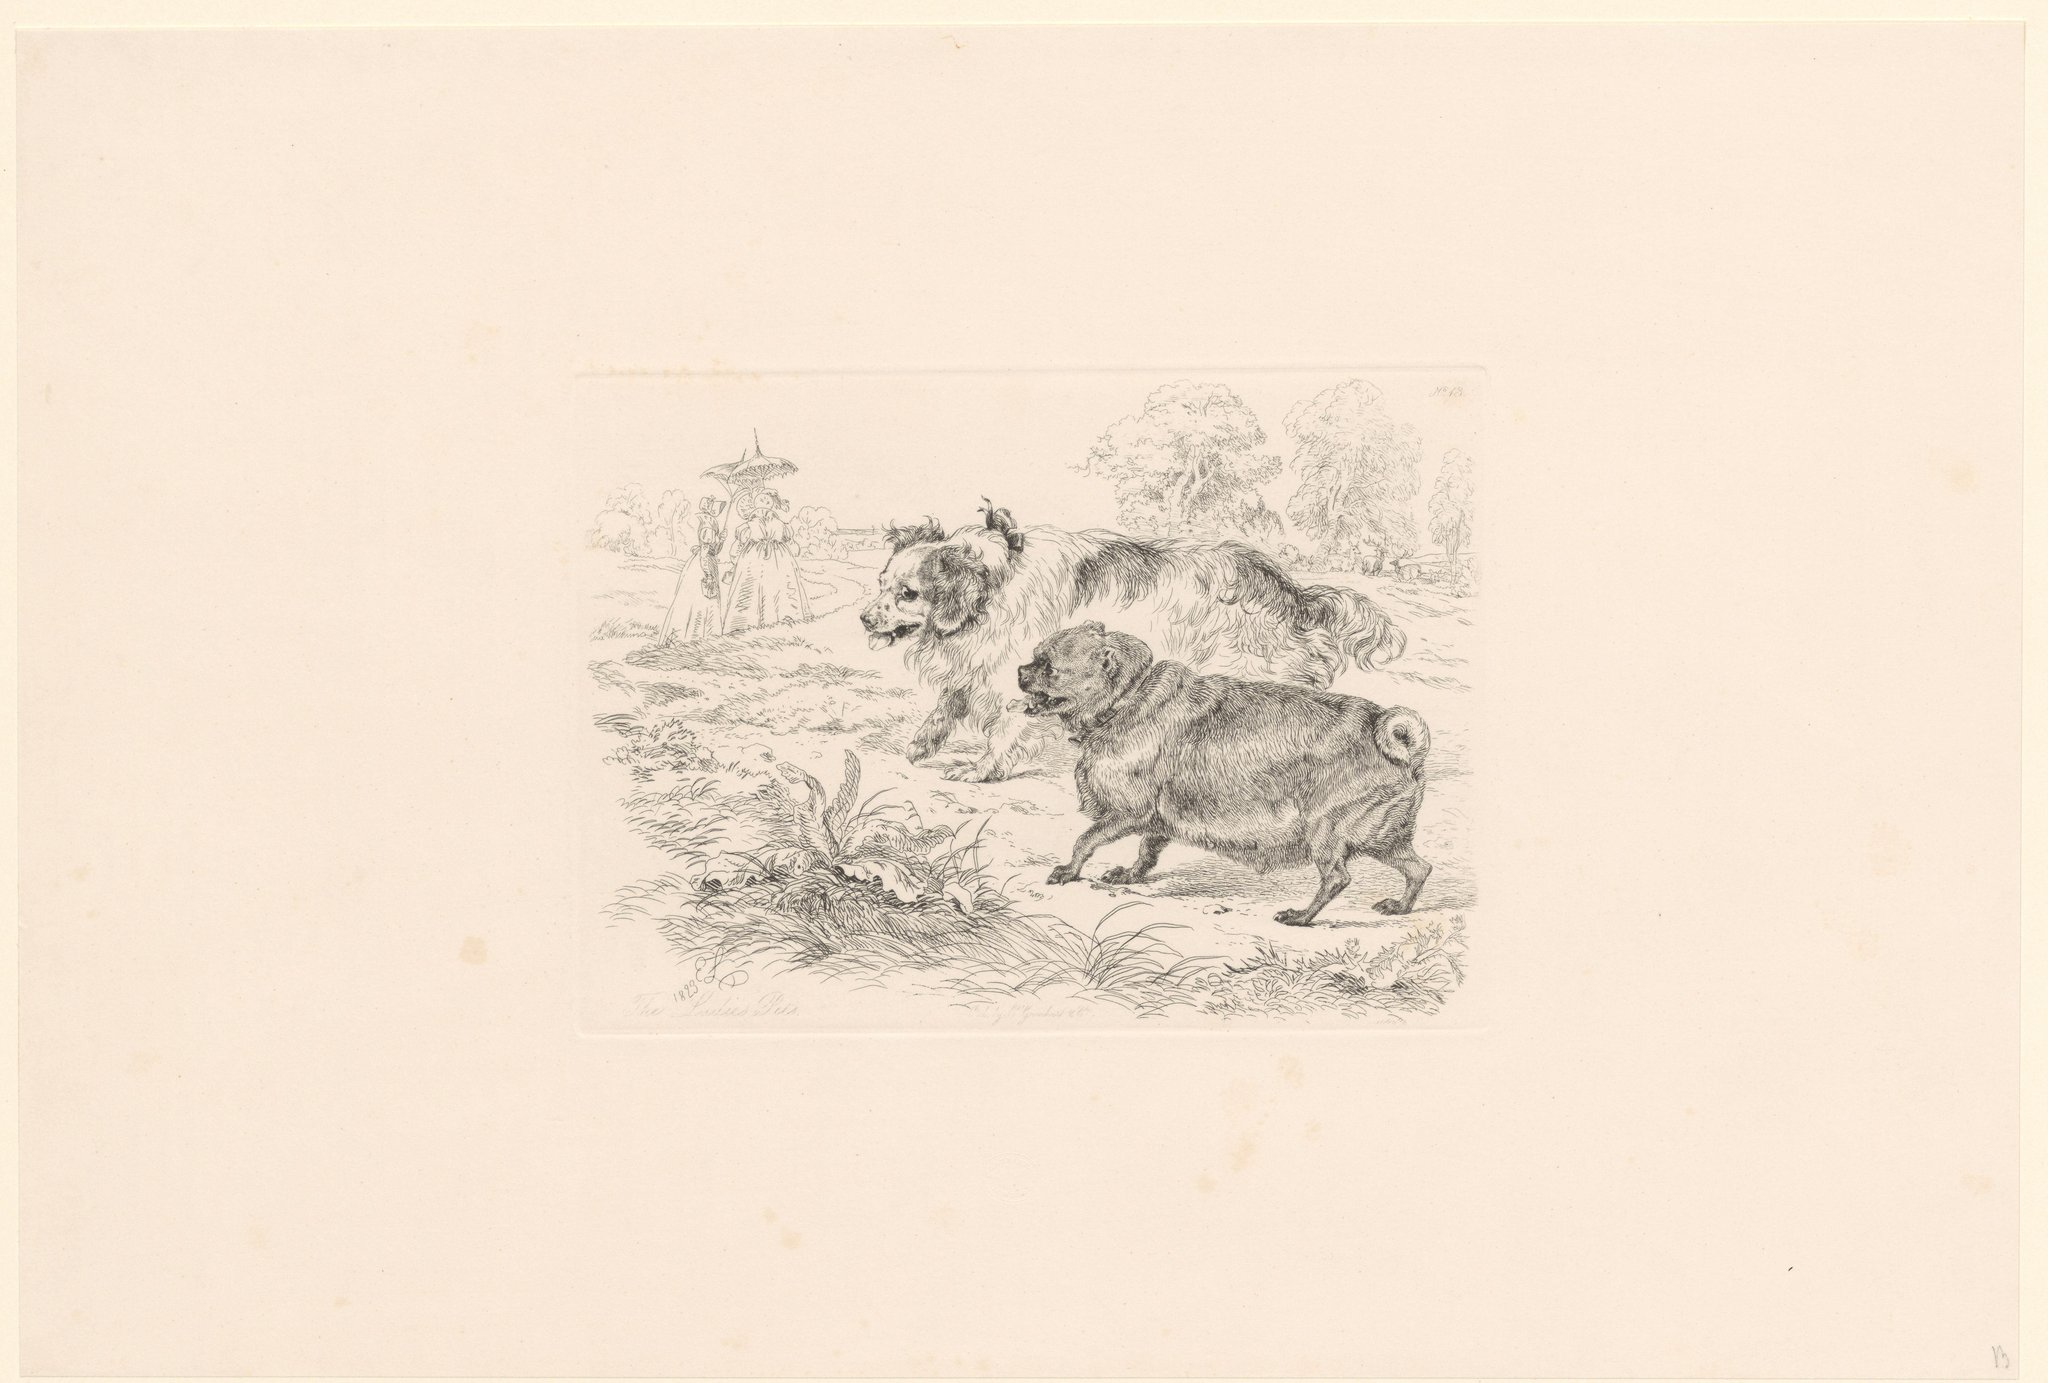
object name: print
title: Twee mollige honden met strik en bel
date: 1823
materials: paper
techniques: etching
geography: london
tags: taming, domestication of animals; tamed or domesticated animal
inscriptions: check stamp: Lugt 4736, collector's mark: Lugt 2228